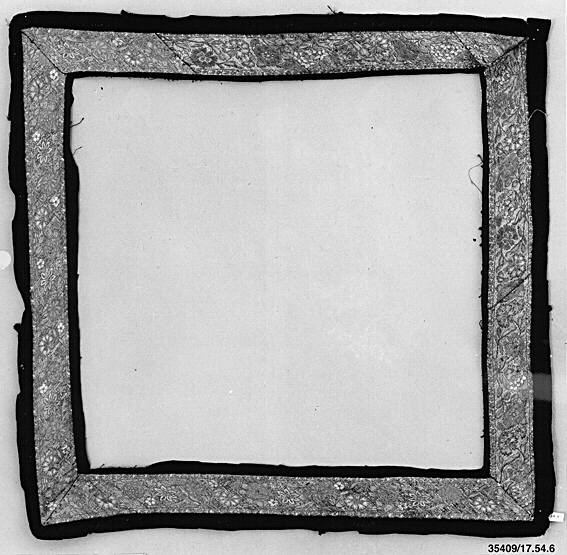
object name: textile fragment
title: Brocade Fragment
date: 1701-1800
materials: gold, silk, thread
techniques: brocade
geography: iran